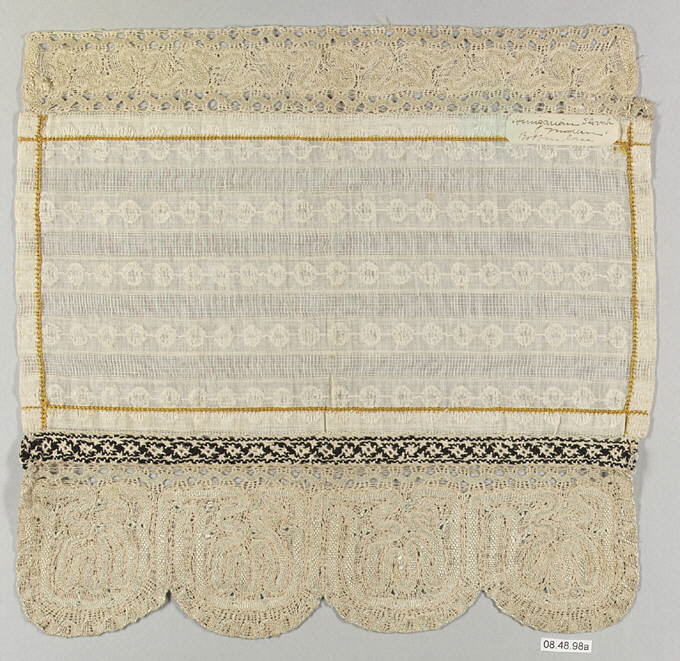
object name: cap fragment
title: Detail from a cap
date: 1801-1833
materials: thread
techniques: lace